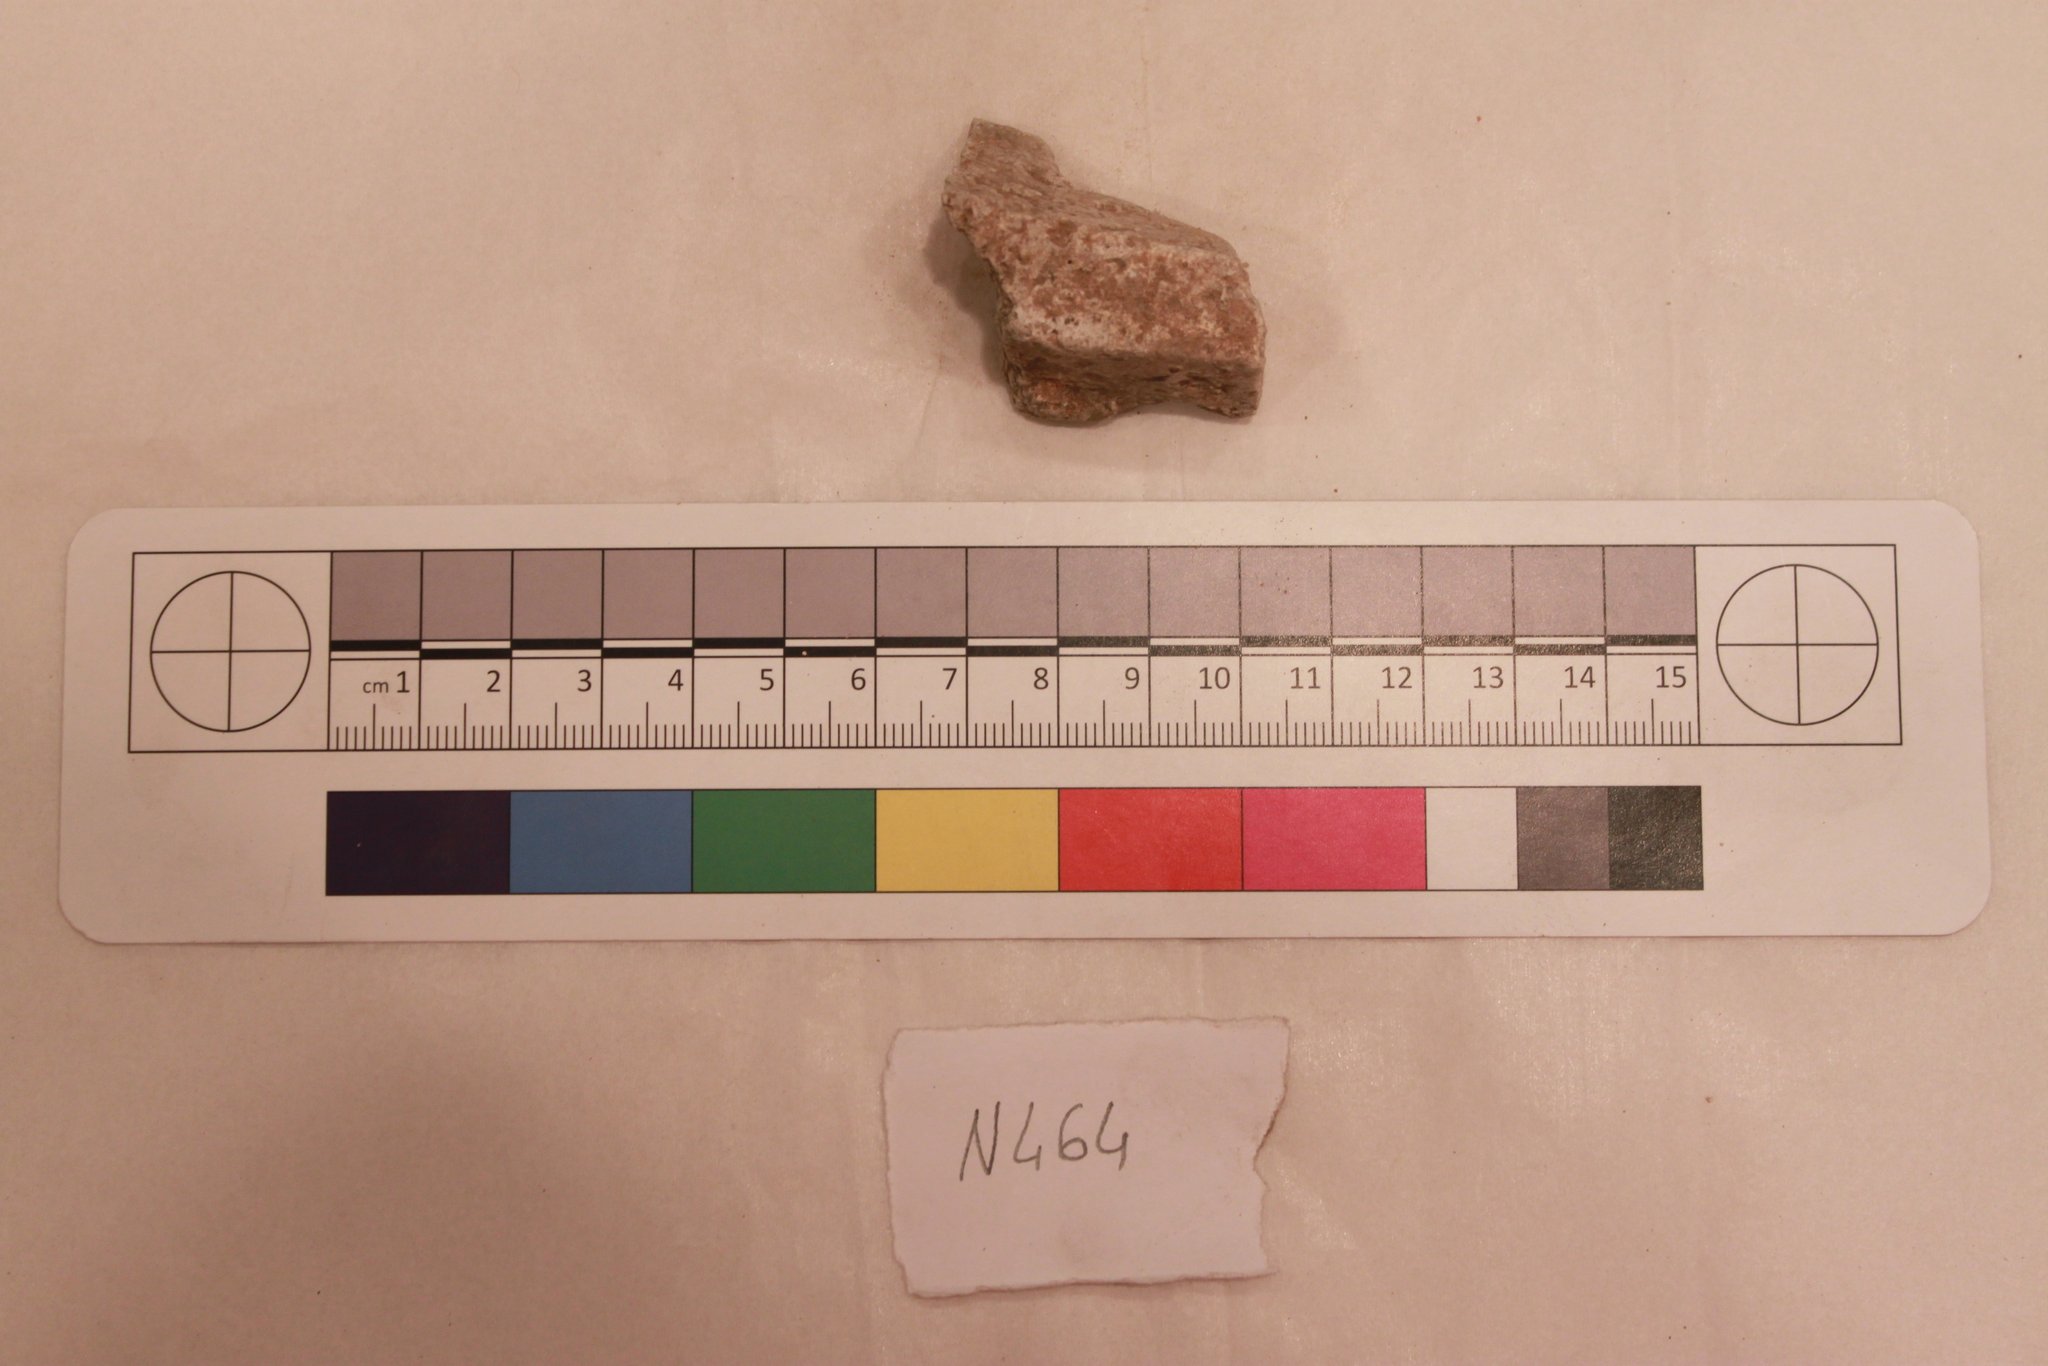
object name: fragment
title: Stucco Fragment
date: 701-1200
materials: plaster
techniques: carving, painting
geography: iran